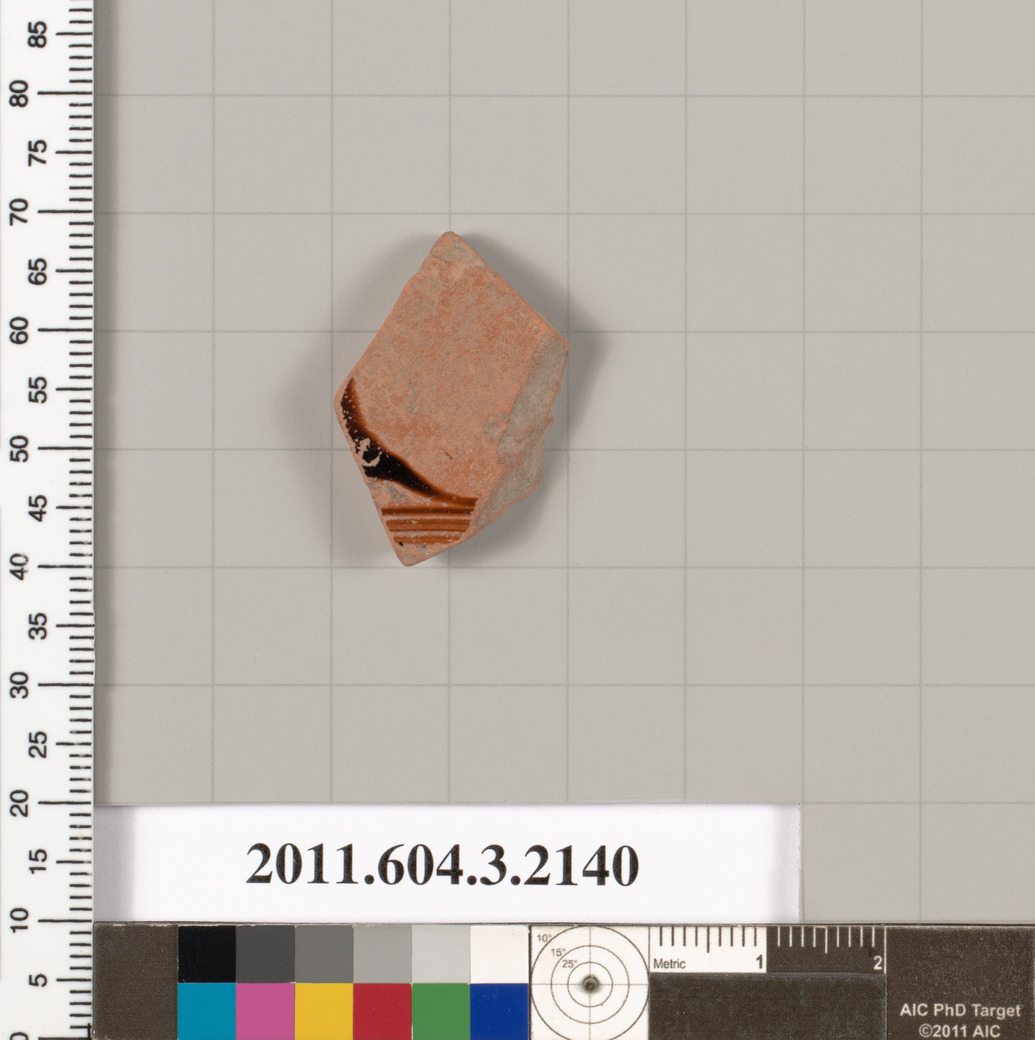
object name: kylix fragment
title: Terracotta fragment of a kylix (drinking cup)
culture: greek, attic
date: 534-468 BCE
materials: terracotta